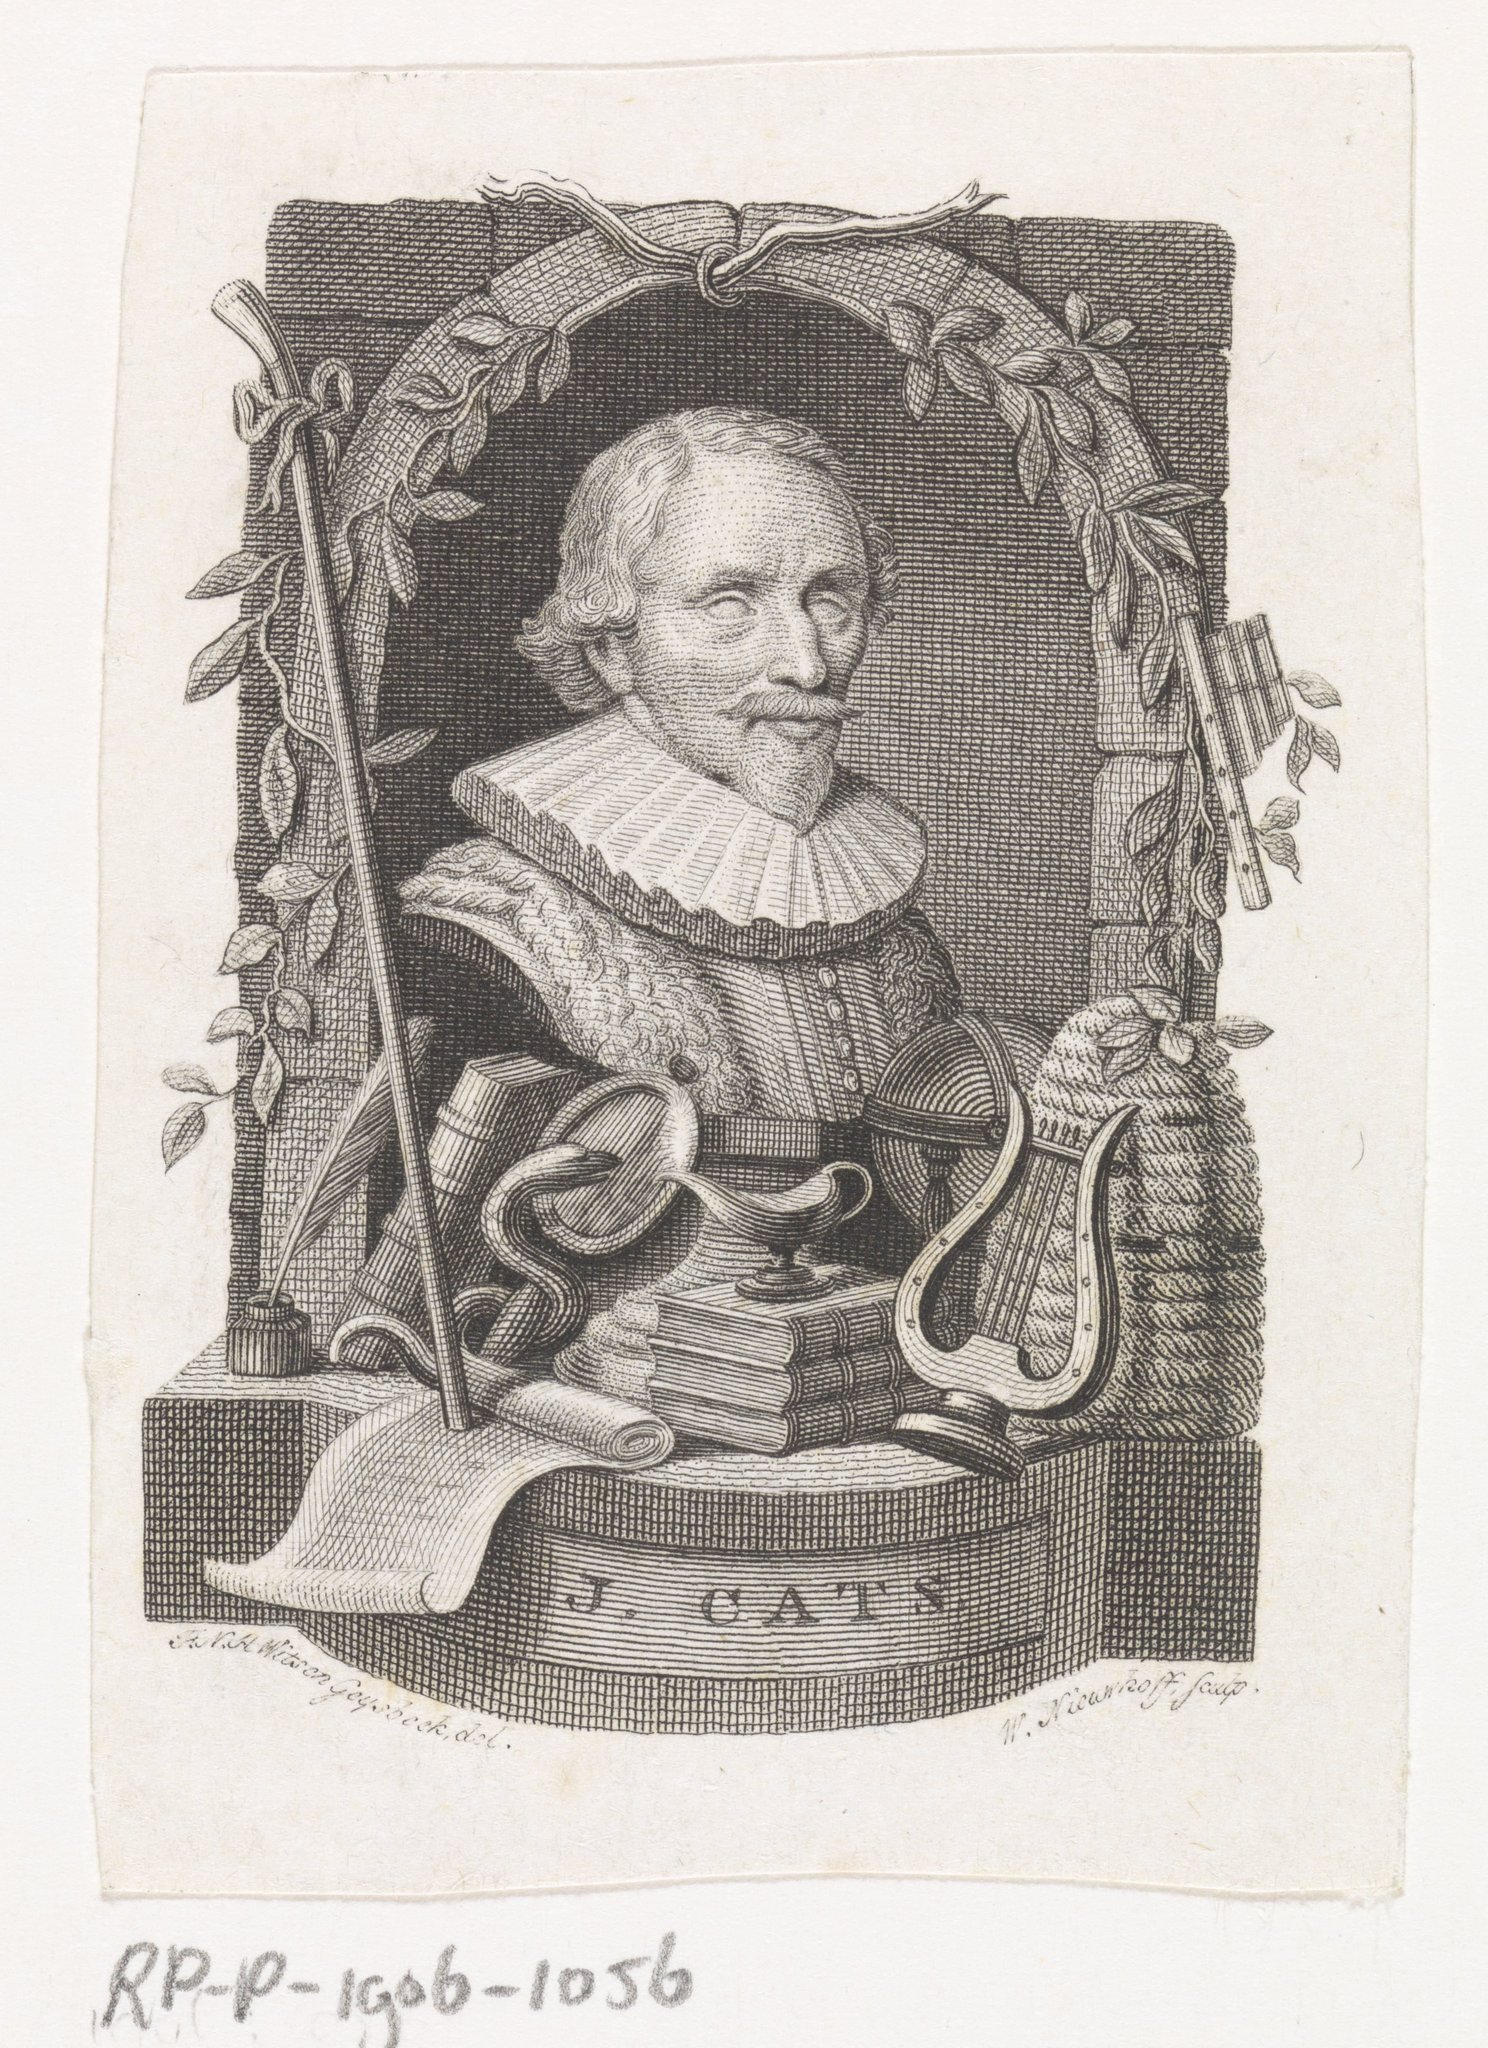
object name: print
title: Borstbeeld van Jacob Cats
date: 1800-1837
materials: paper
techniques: engraving, etching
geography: amsterdam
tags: jacob cats (1577-1660), prudence, 'prudentia'; 'prudenza' (ripa) ~ one of the four cardinal virtues, lyre, cithara, psaltery, book, bee-hive, historical persons (+ (full) bust portrait)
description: Borstbeeld van Jacob Cats, naar rechts, staand in een nis. Onder het borstbeeld liggen verschillende attributen, die verwijzen naar Cats als dichter, zoals boeken, inktpot en en penneveer, een globe, een lier, een fluit. De bijenkorf verwijst naar de Amsterdamse schouwburg. De slang en de spiegel duiden op de kardinale deugd van de Voorzichtigheid en Wijsheid.